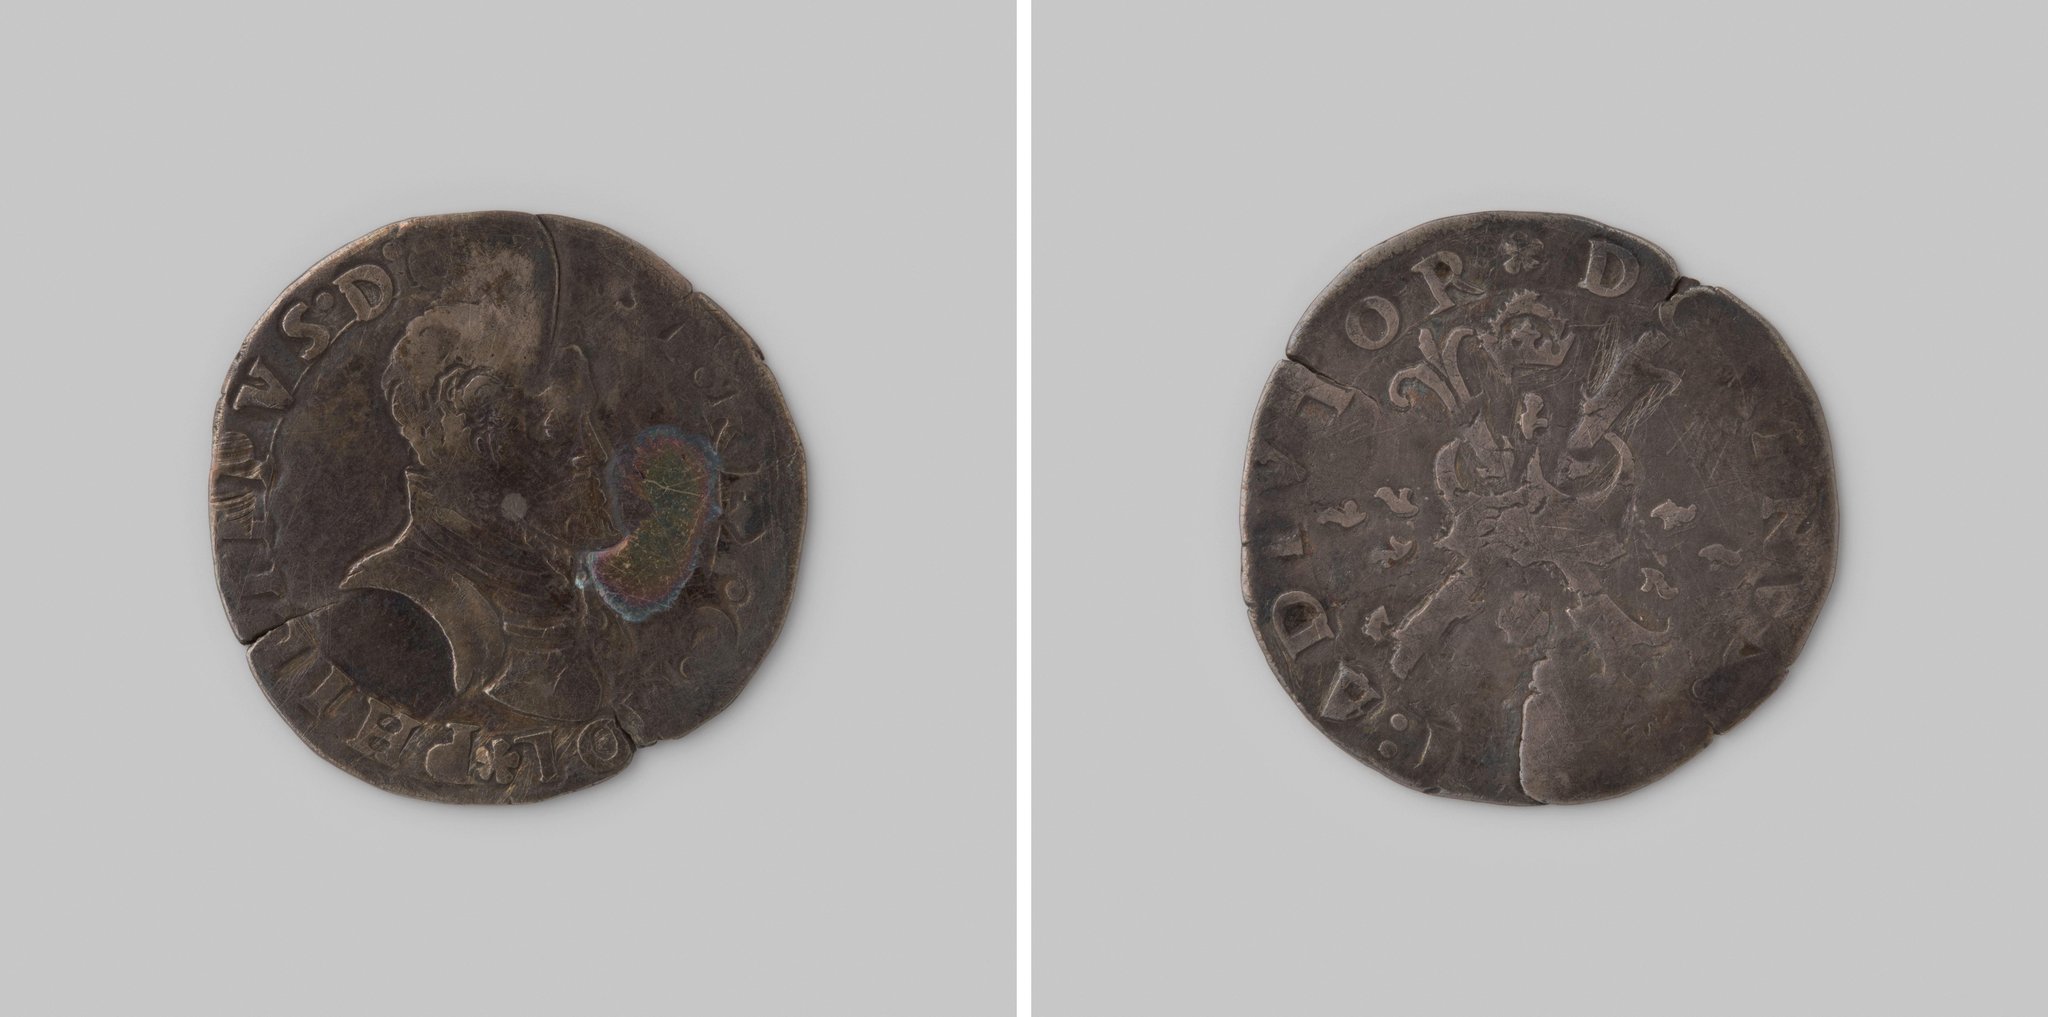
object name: coin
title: Holland, Philips II, tiende philipsdaalder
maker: philip ii of spain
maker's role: koning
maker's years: 1527-1598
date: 1555-1580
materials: silver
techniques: striking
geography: dordrecht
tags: philip ii of spain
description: Zilveren munt. Voorzijde: geharnast borstbeeld van Philips II naar rechts. Keerzijde: onder kroon gekruiste knoestige stokken, in het midden vuursteen met vonken.